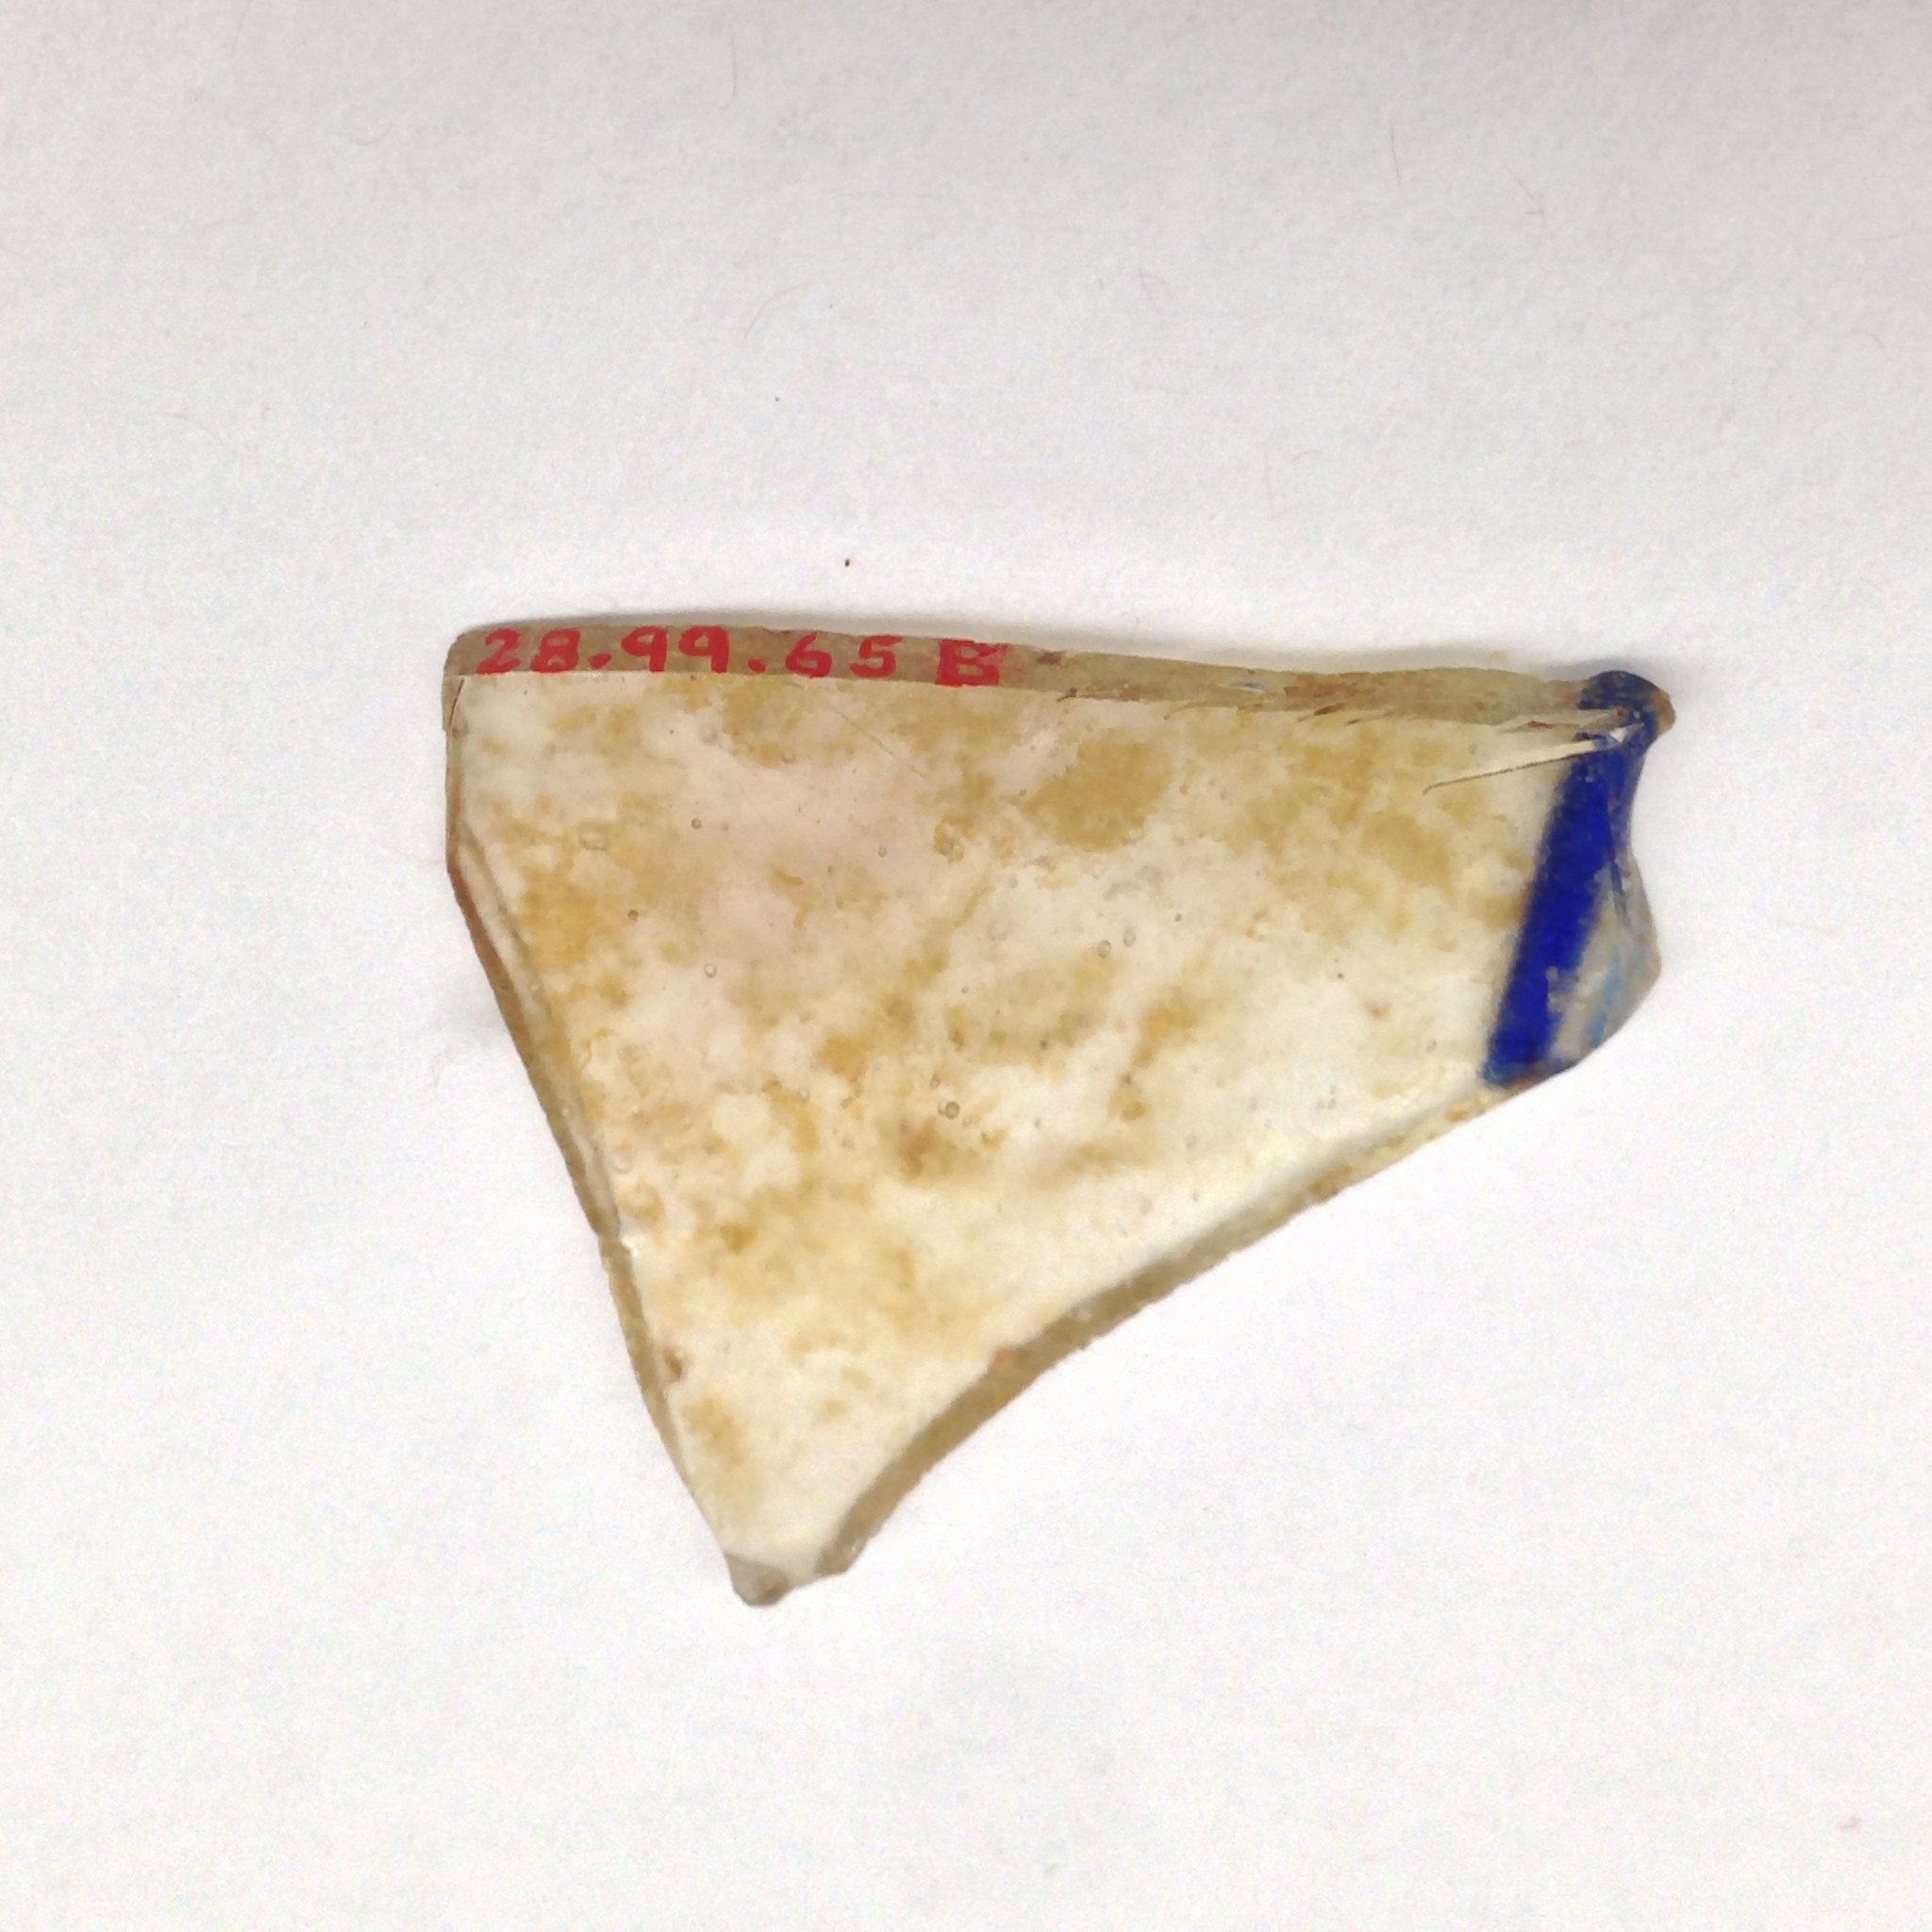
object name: glass fragment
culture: crusader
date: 1201-1300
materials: glass